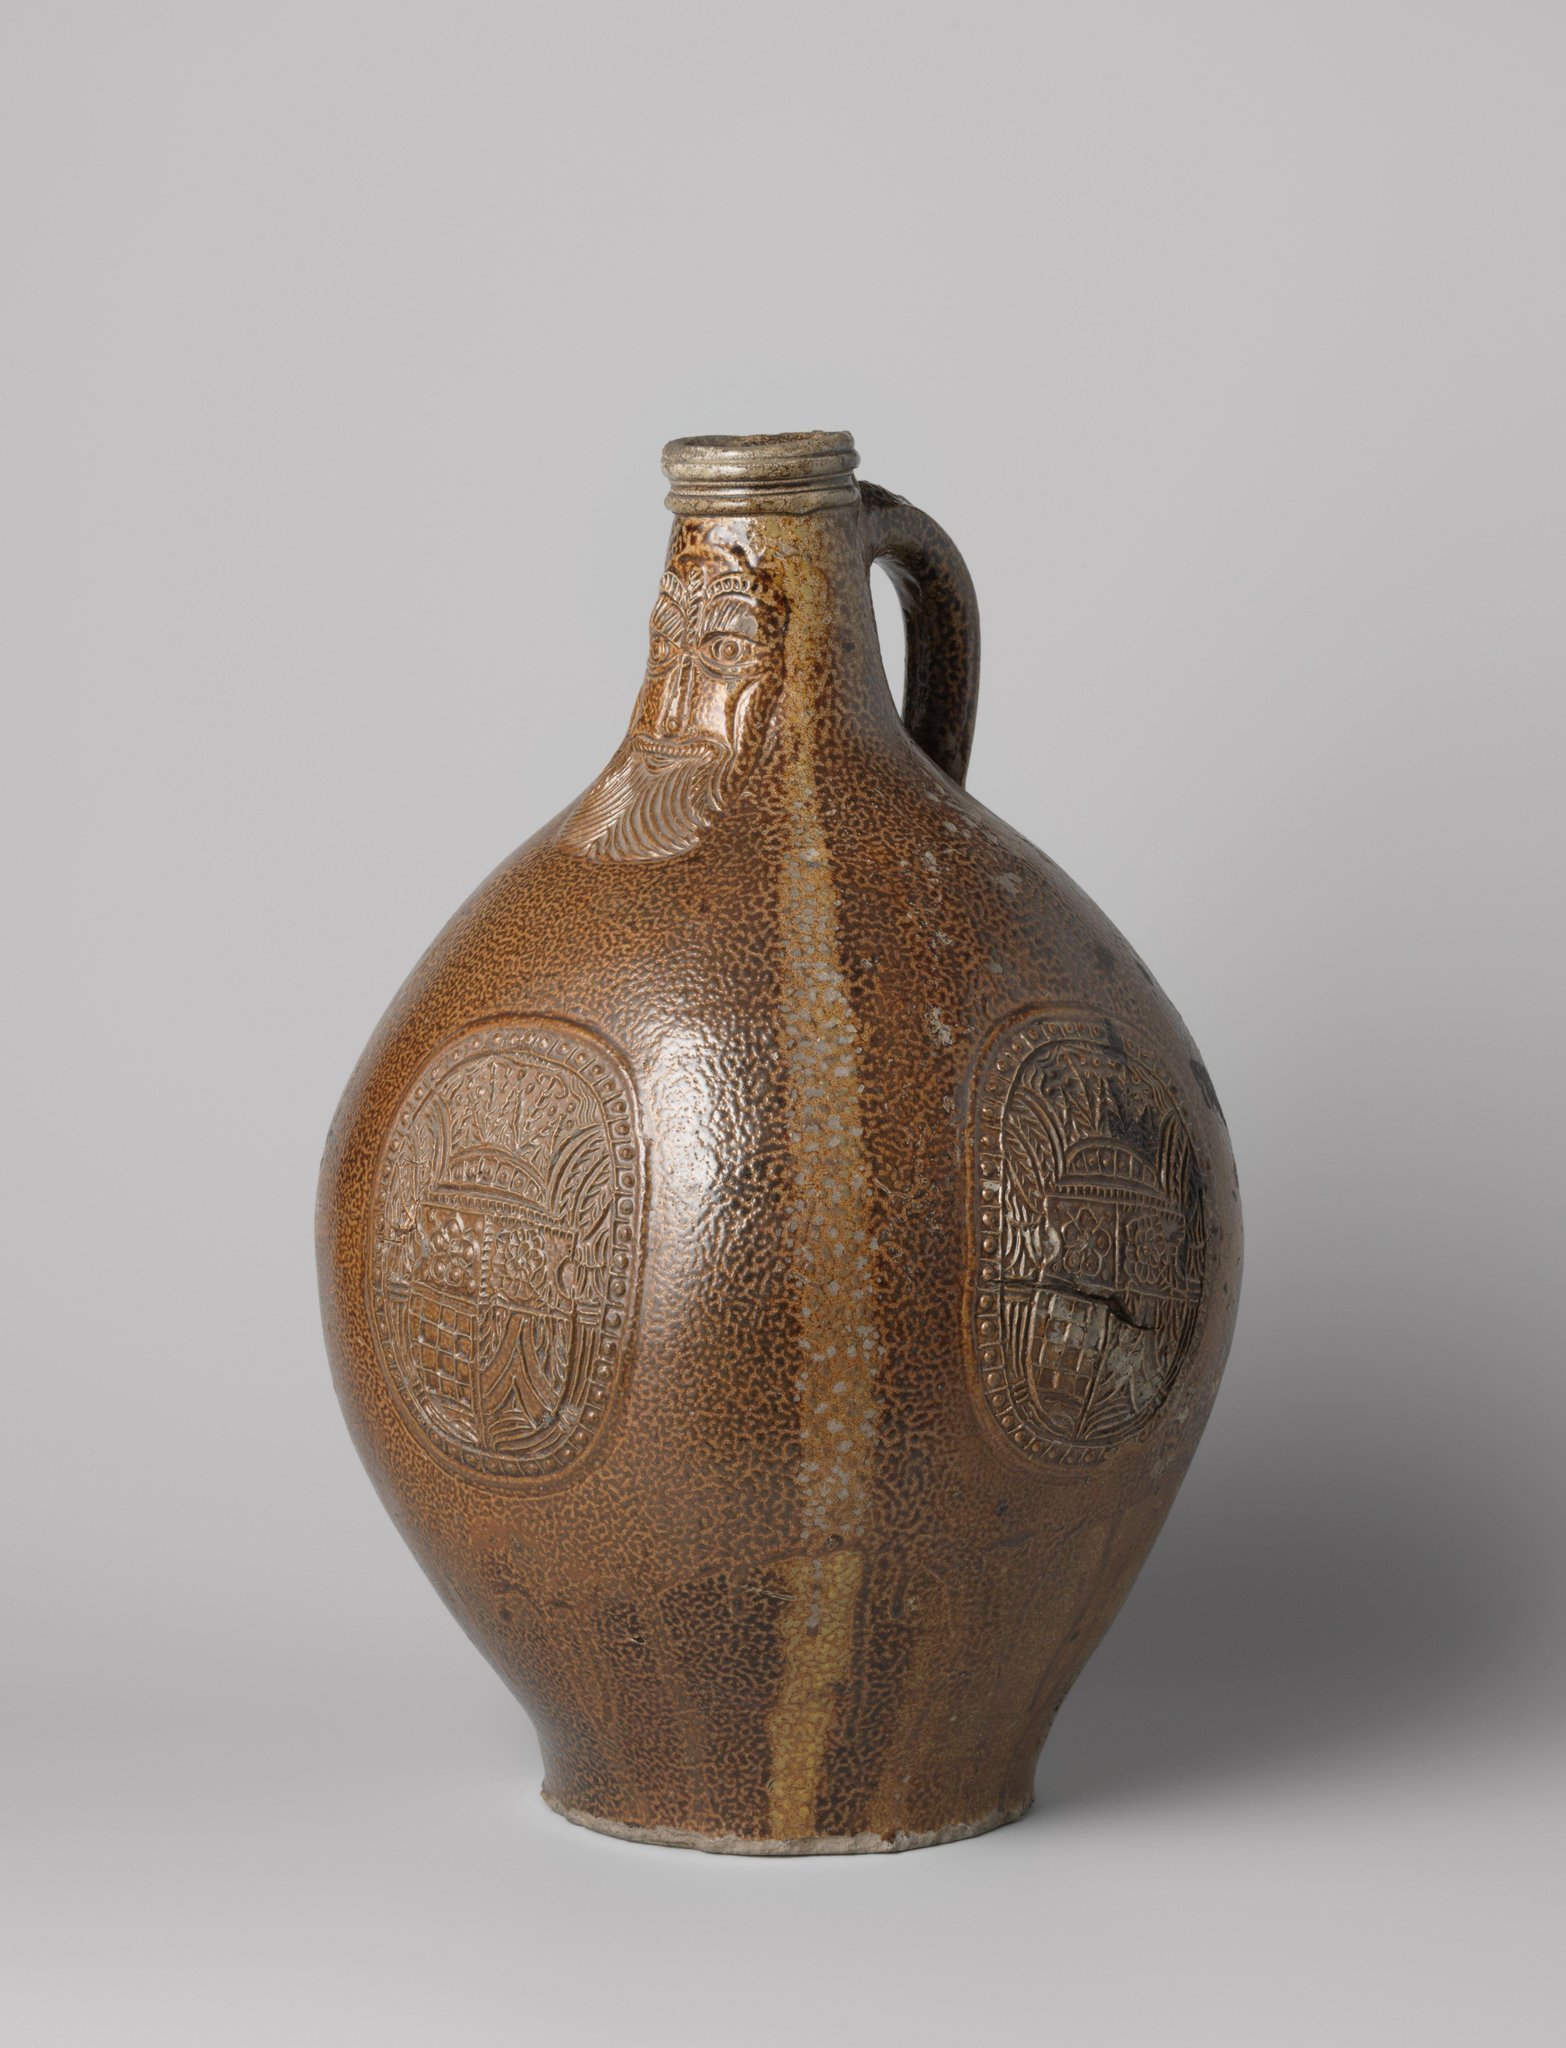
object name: jug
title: Jug (Bartmann jug) with a coat of arms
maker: Anonymous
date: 1650-1750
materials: engobe, glaze, stoneware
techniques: firing, forming, relief, turning, vitrification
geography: frechen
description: Kruik (baardmankruik) van steengoed op standvlak met een bolvormig lichaam en smalle nek. Het C-vormige oor is bevestigd aan de nek en de schouder. Profielen op de nek. Bedekt met een bruine engobe. Driemaal een gedrukt en opgelegd medaillon met drie gekroonde wapens. Op de nek, doorlopend op de schouder, een baardman. Frechen.